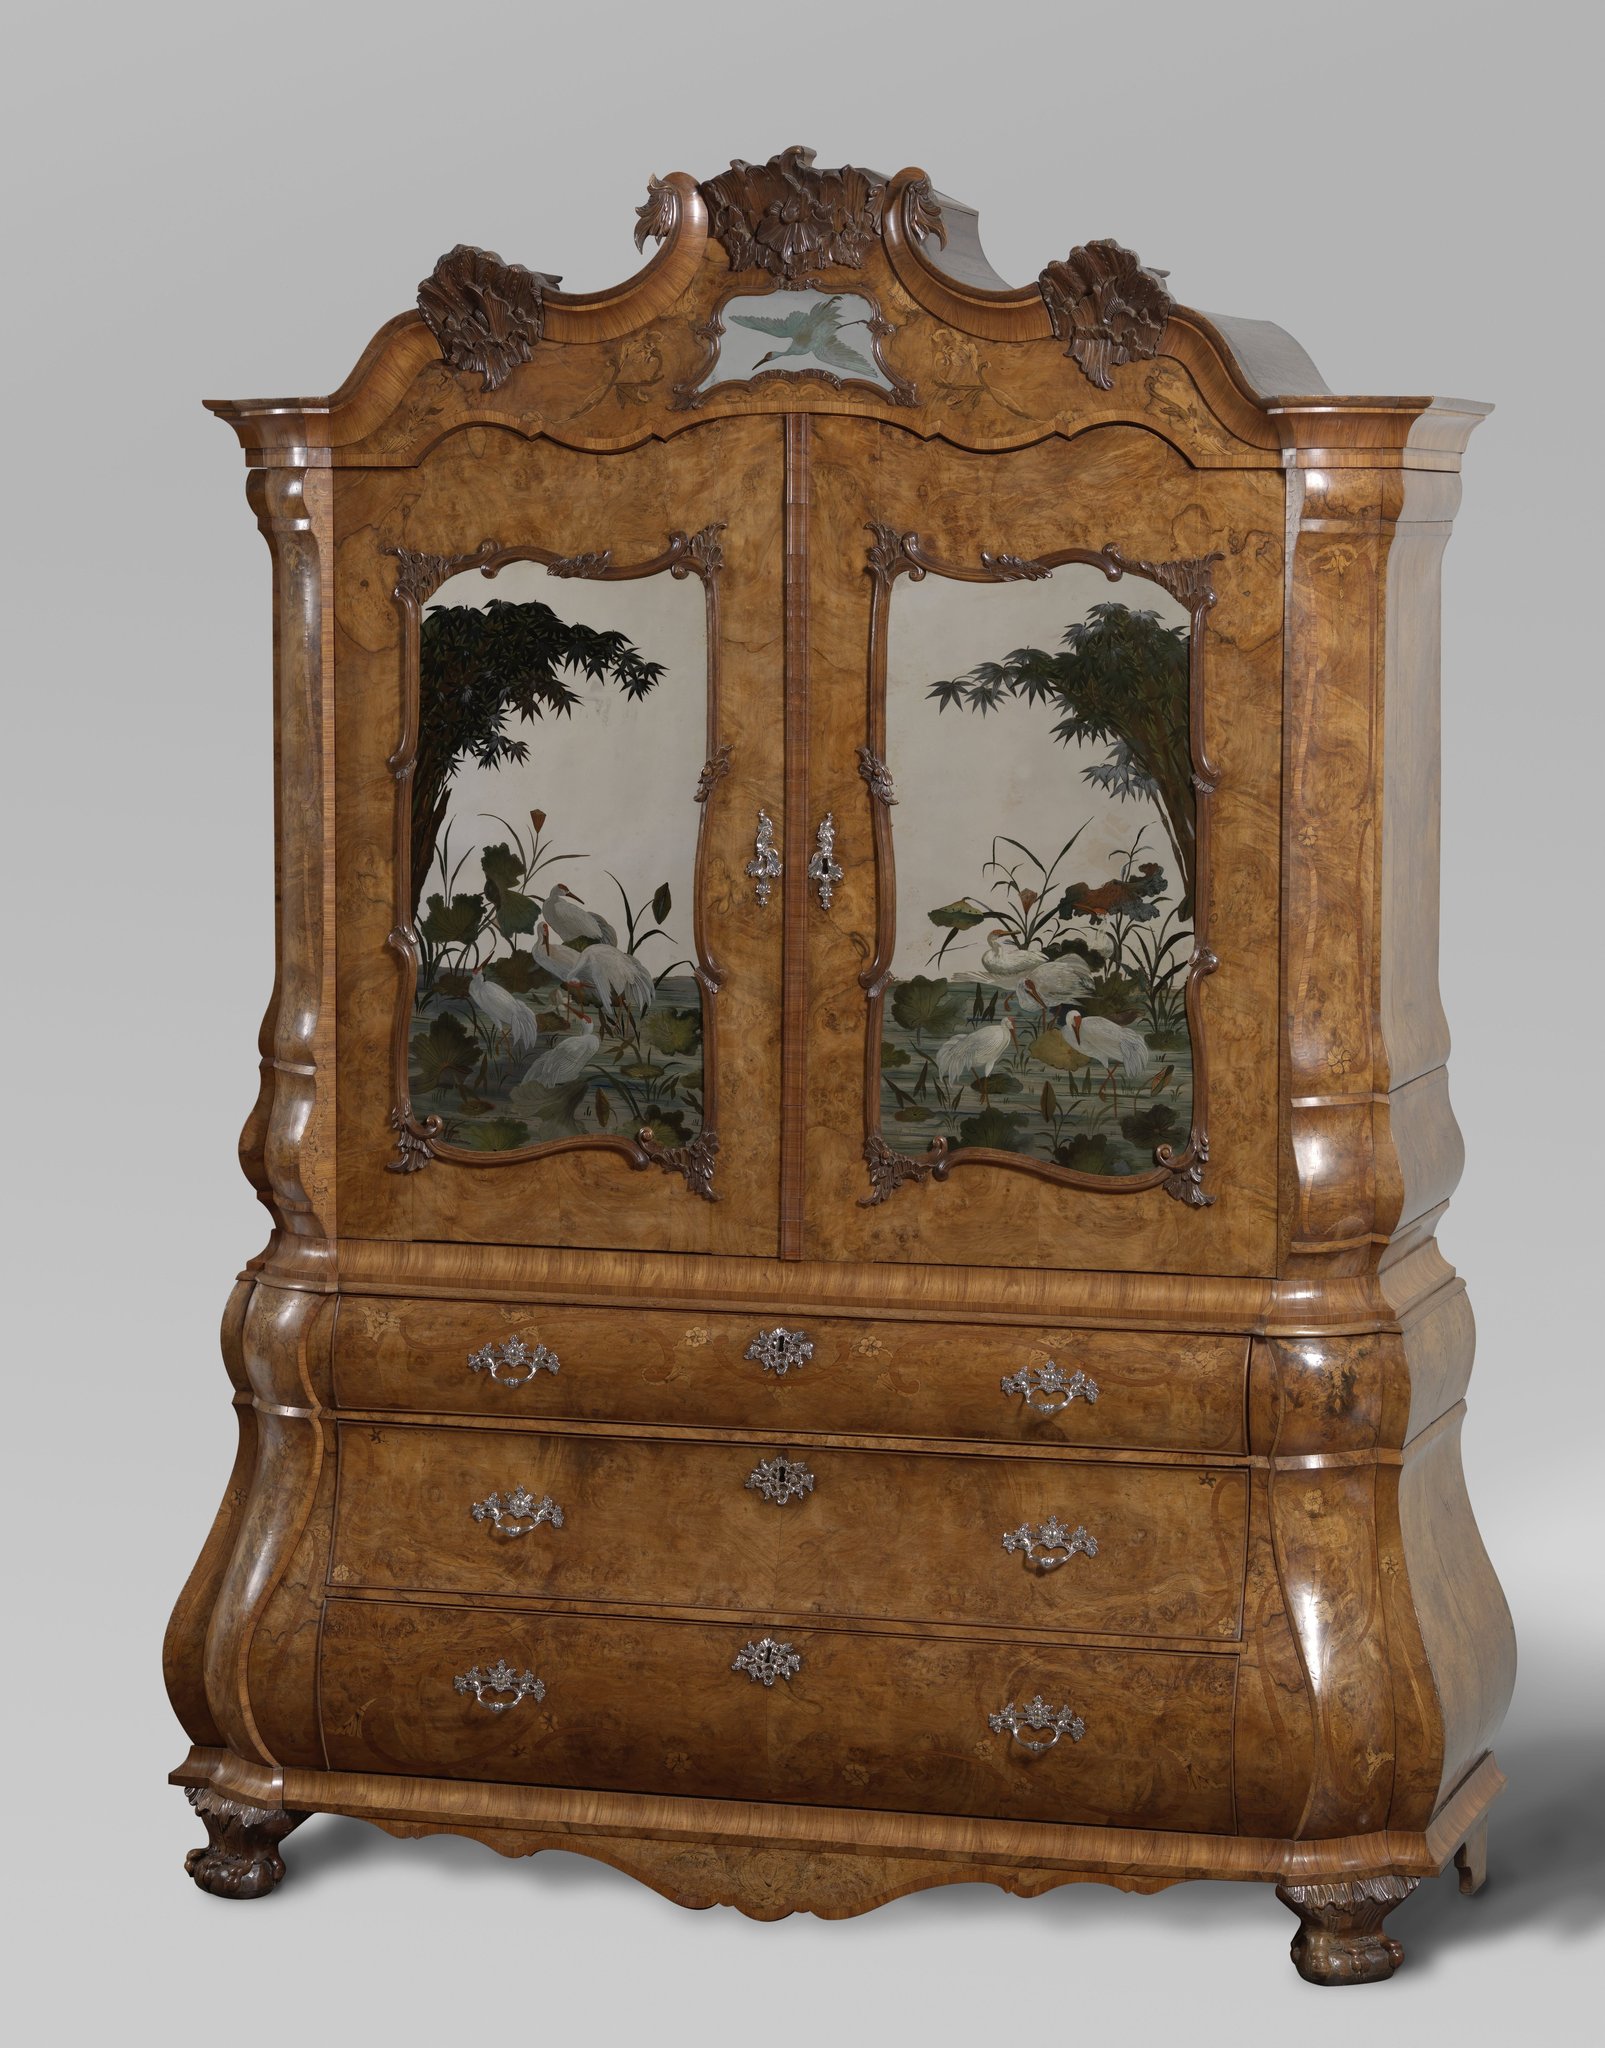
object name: cabinet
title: Mirrored cabinet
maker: dirk froger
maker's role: silversmith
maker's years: 1708-1780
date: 1764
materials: amalgam, glass, wood, silver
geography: amsterdam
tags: shore-birds and wading-birds: crane, ornaments ~ art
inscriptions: town mark, date letter: ‘E’, maker's mark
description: The cabinetmaker wanted to give this large, heavy cabinet a Rococo shape, but did not succeed in avoiding straight angles and mouldings. Because the silver is marked with a ‘year letter’, this piece of furniture can be dated rather precisely.